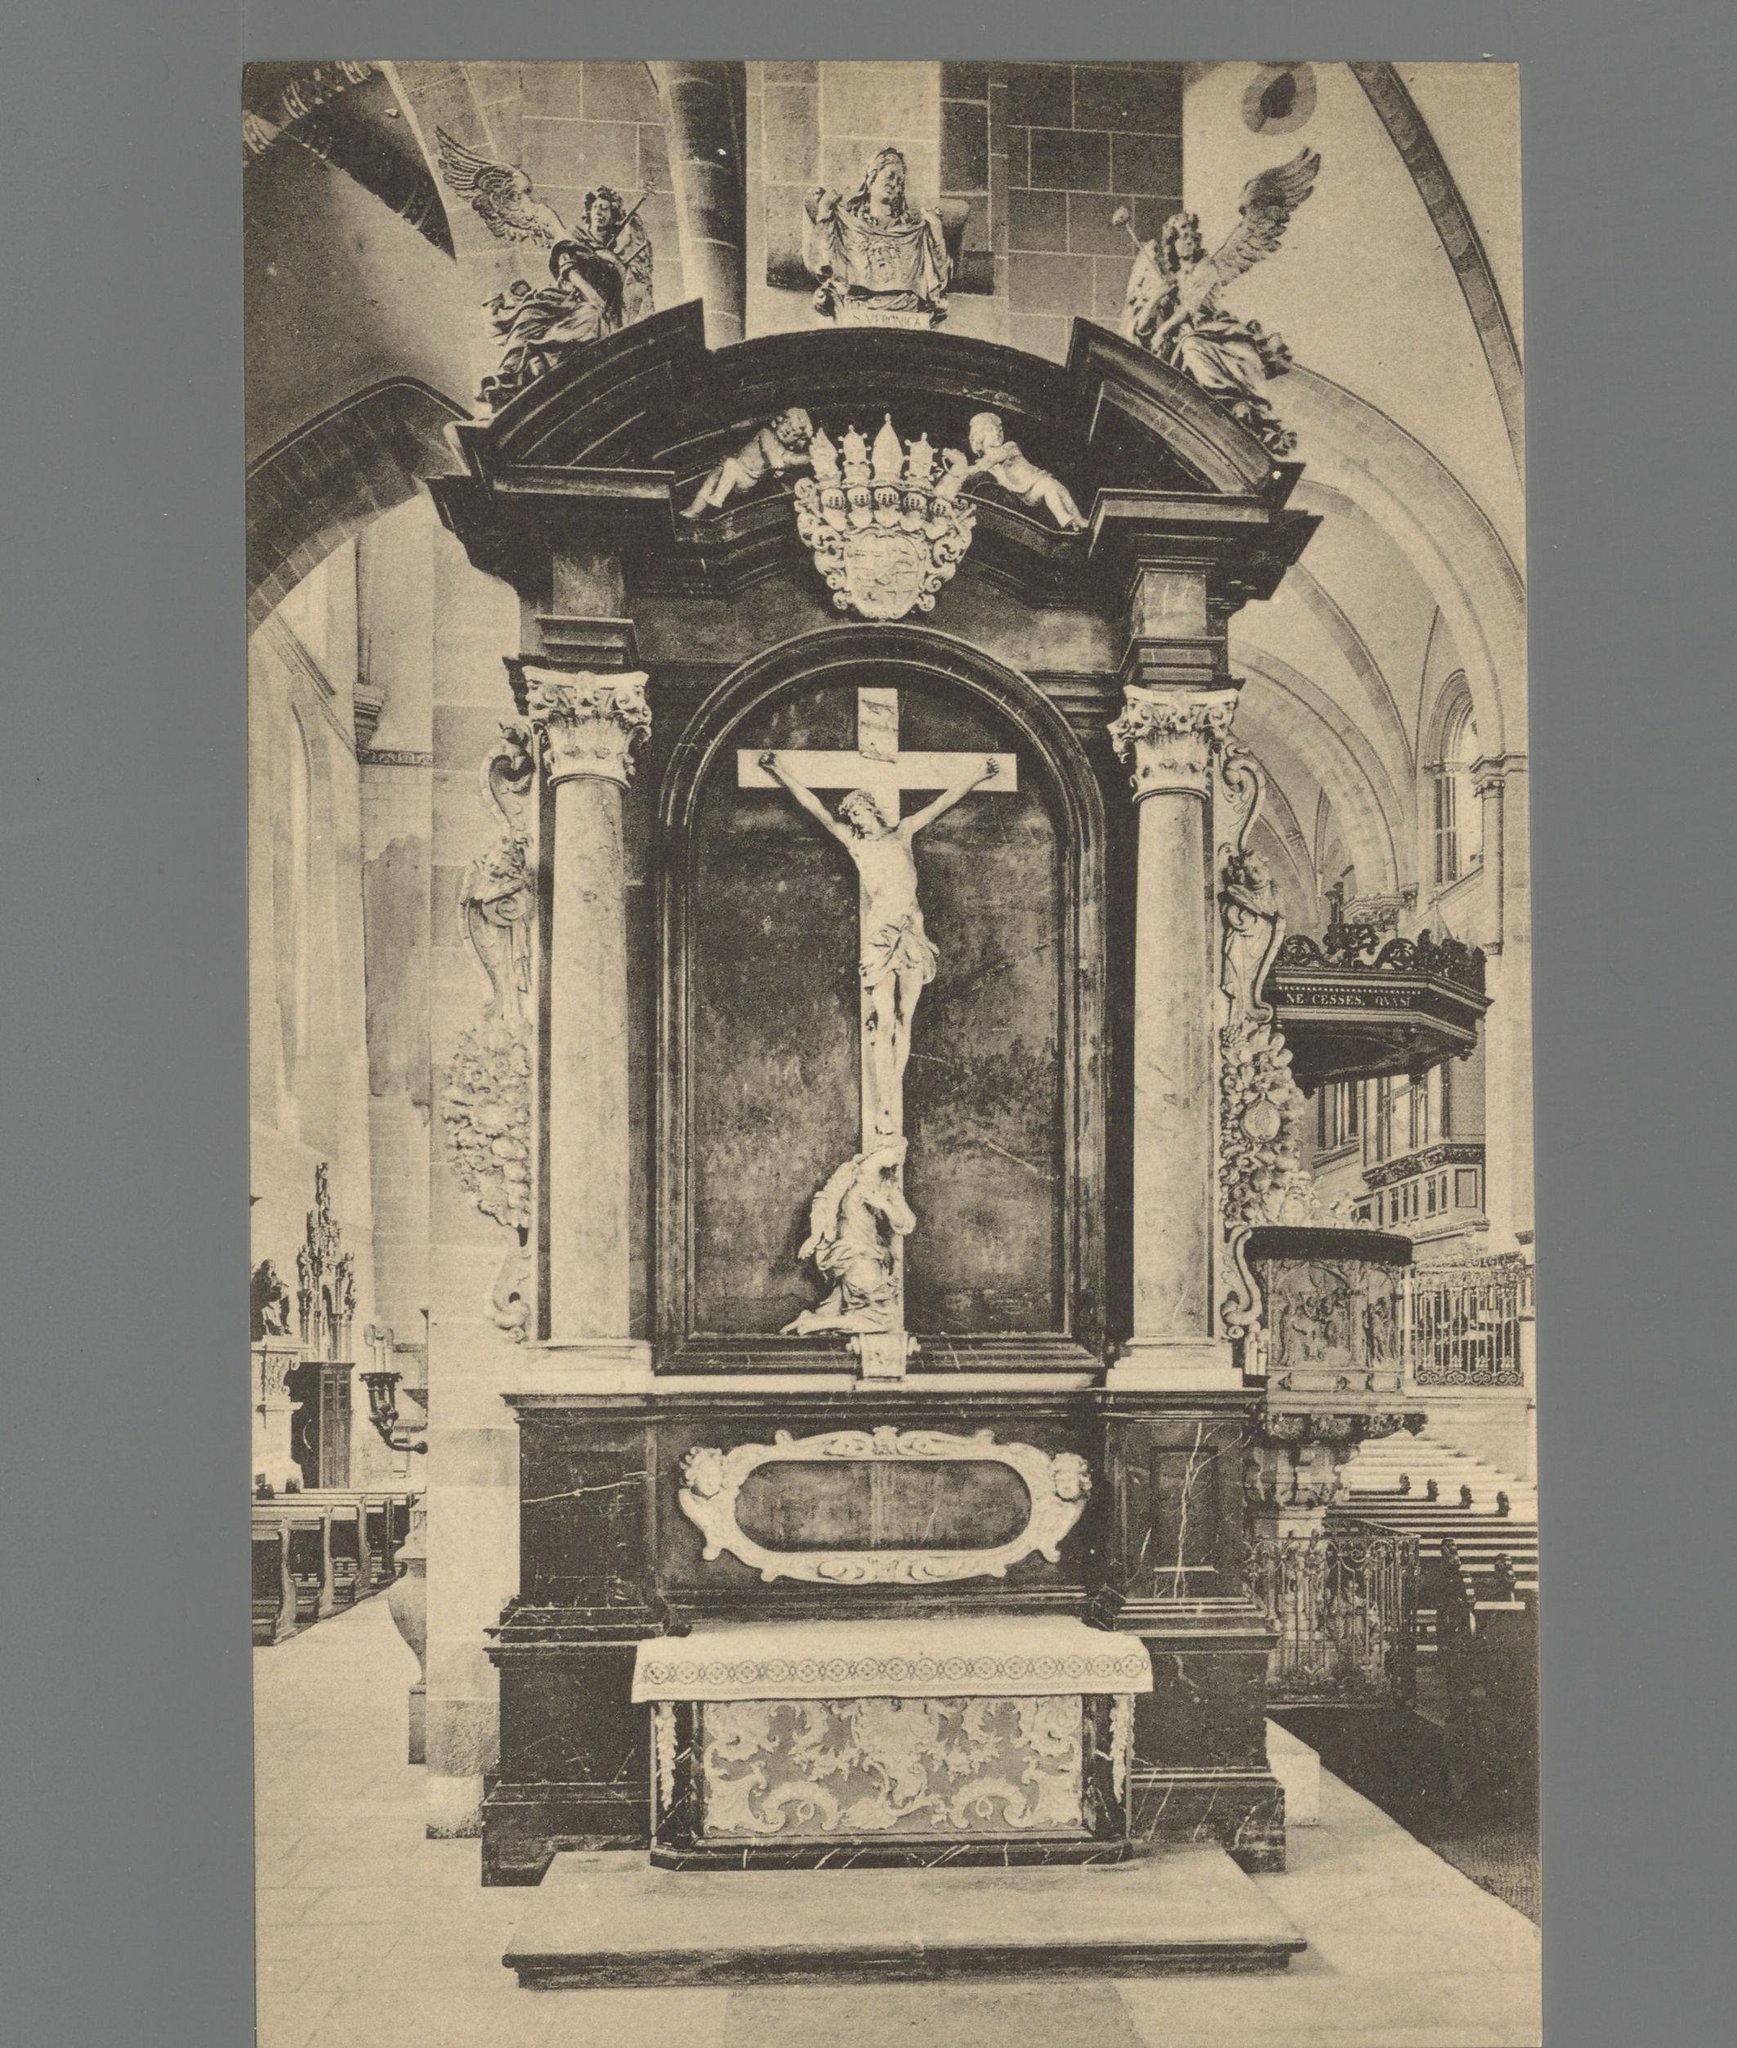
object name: photomechanical print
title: Dom zu Trier. Kreuzaltar (1711)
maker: Anonymous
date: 1905-1930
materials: cardboard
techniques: photograph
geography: trier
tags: interior of church, altar with altar-piece